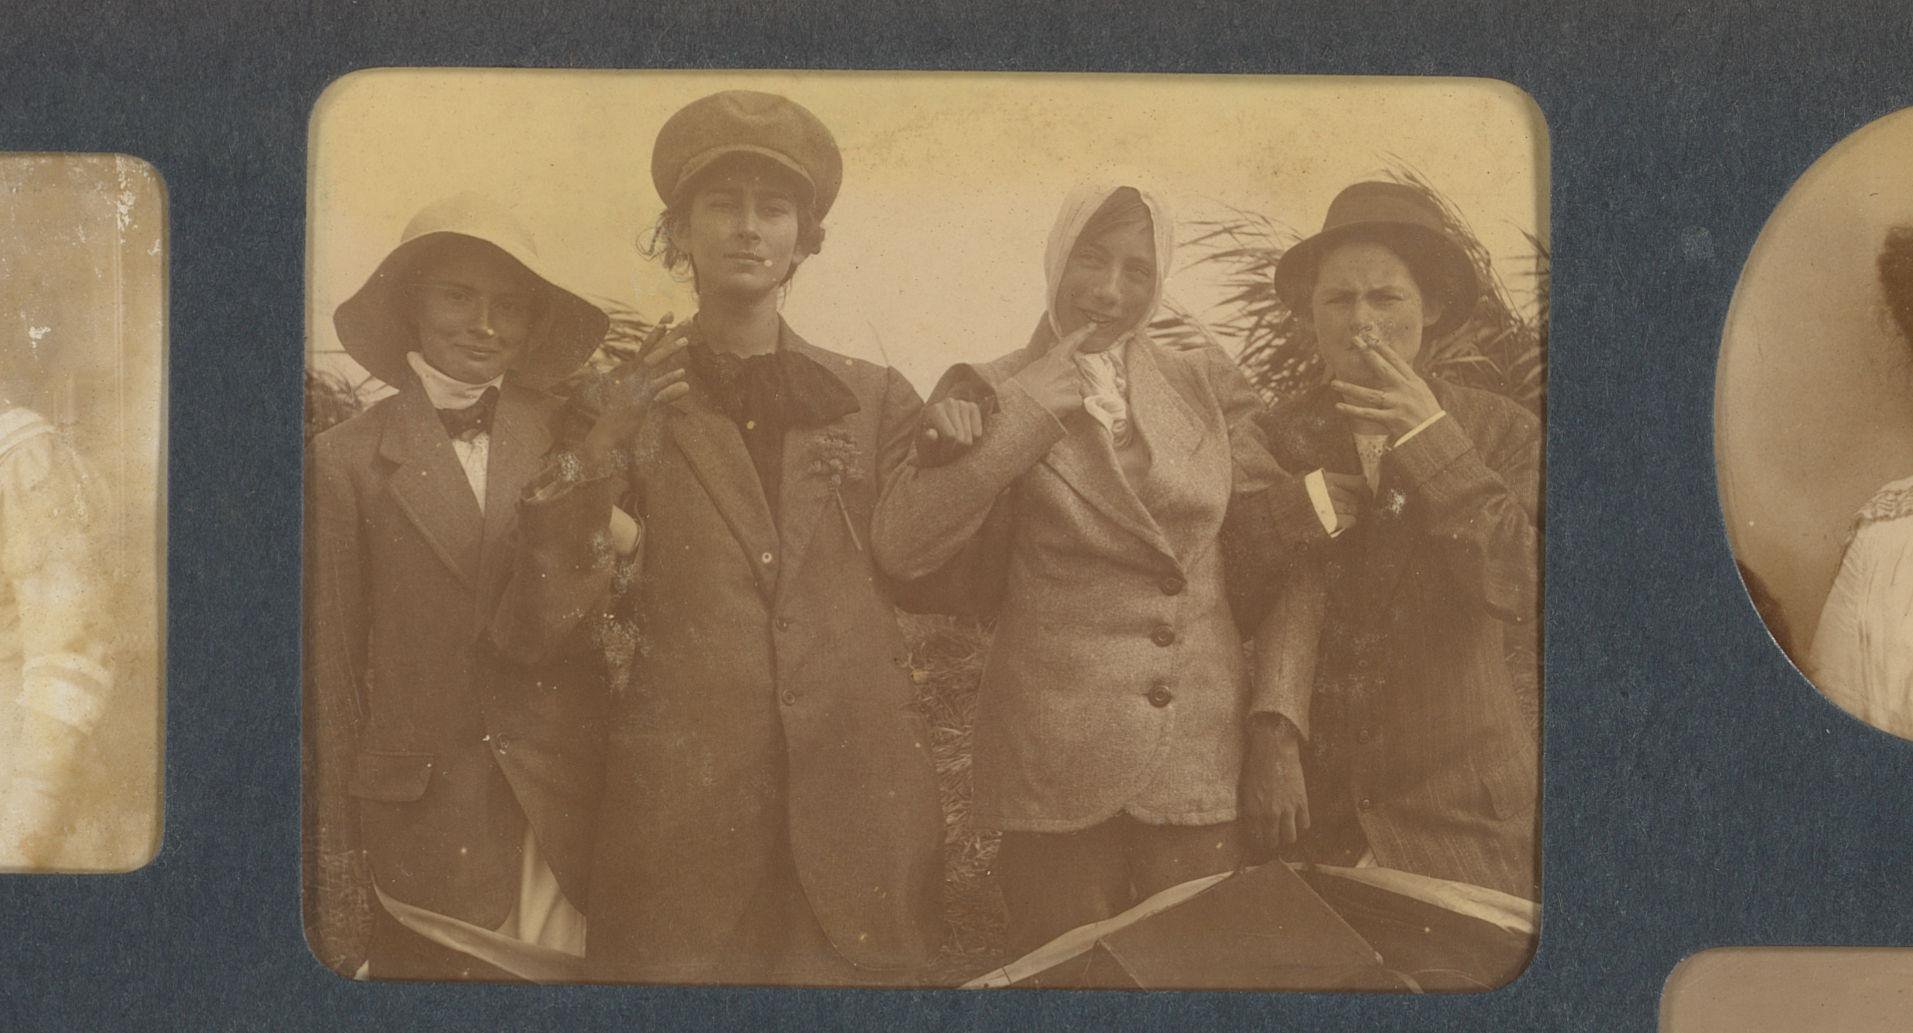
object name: photograph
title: Groepsportret van Pauline van den Bussche, Jenny Wichers, Wiesje Merkus en Alexander Voormolen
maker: Anonymous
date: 1910-1911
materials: paper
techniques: gelatin silver print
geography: gelderland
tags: rotterdam, the hague, artist, sculptor, jenny cornelia henriette wichers (jane), wiesje merkus, adolescent, young woman, maiden, youth, adolescent, friends, anonymous historical persons portrayed in a group, in a group-portrait, gelderland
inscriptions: inscription: ‘Pauline Jenny L[...] Wiesje’